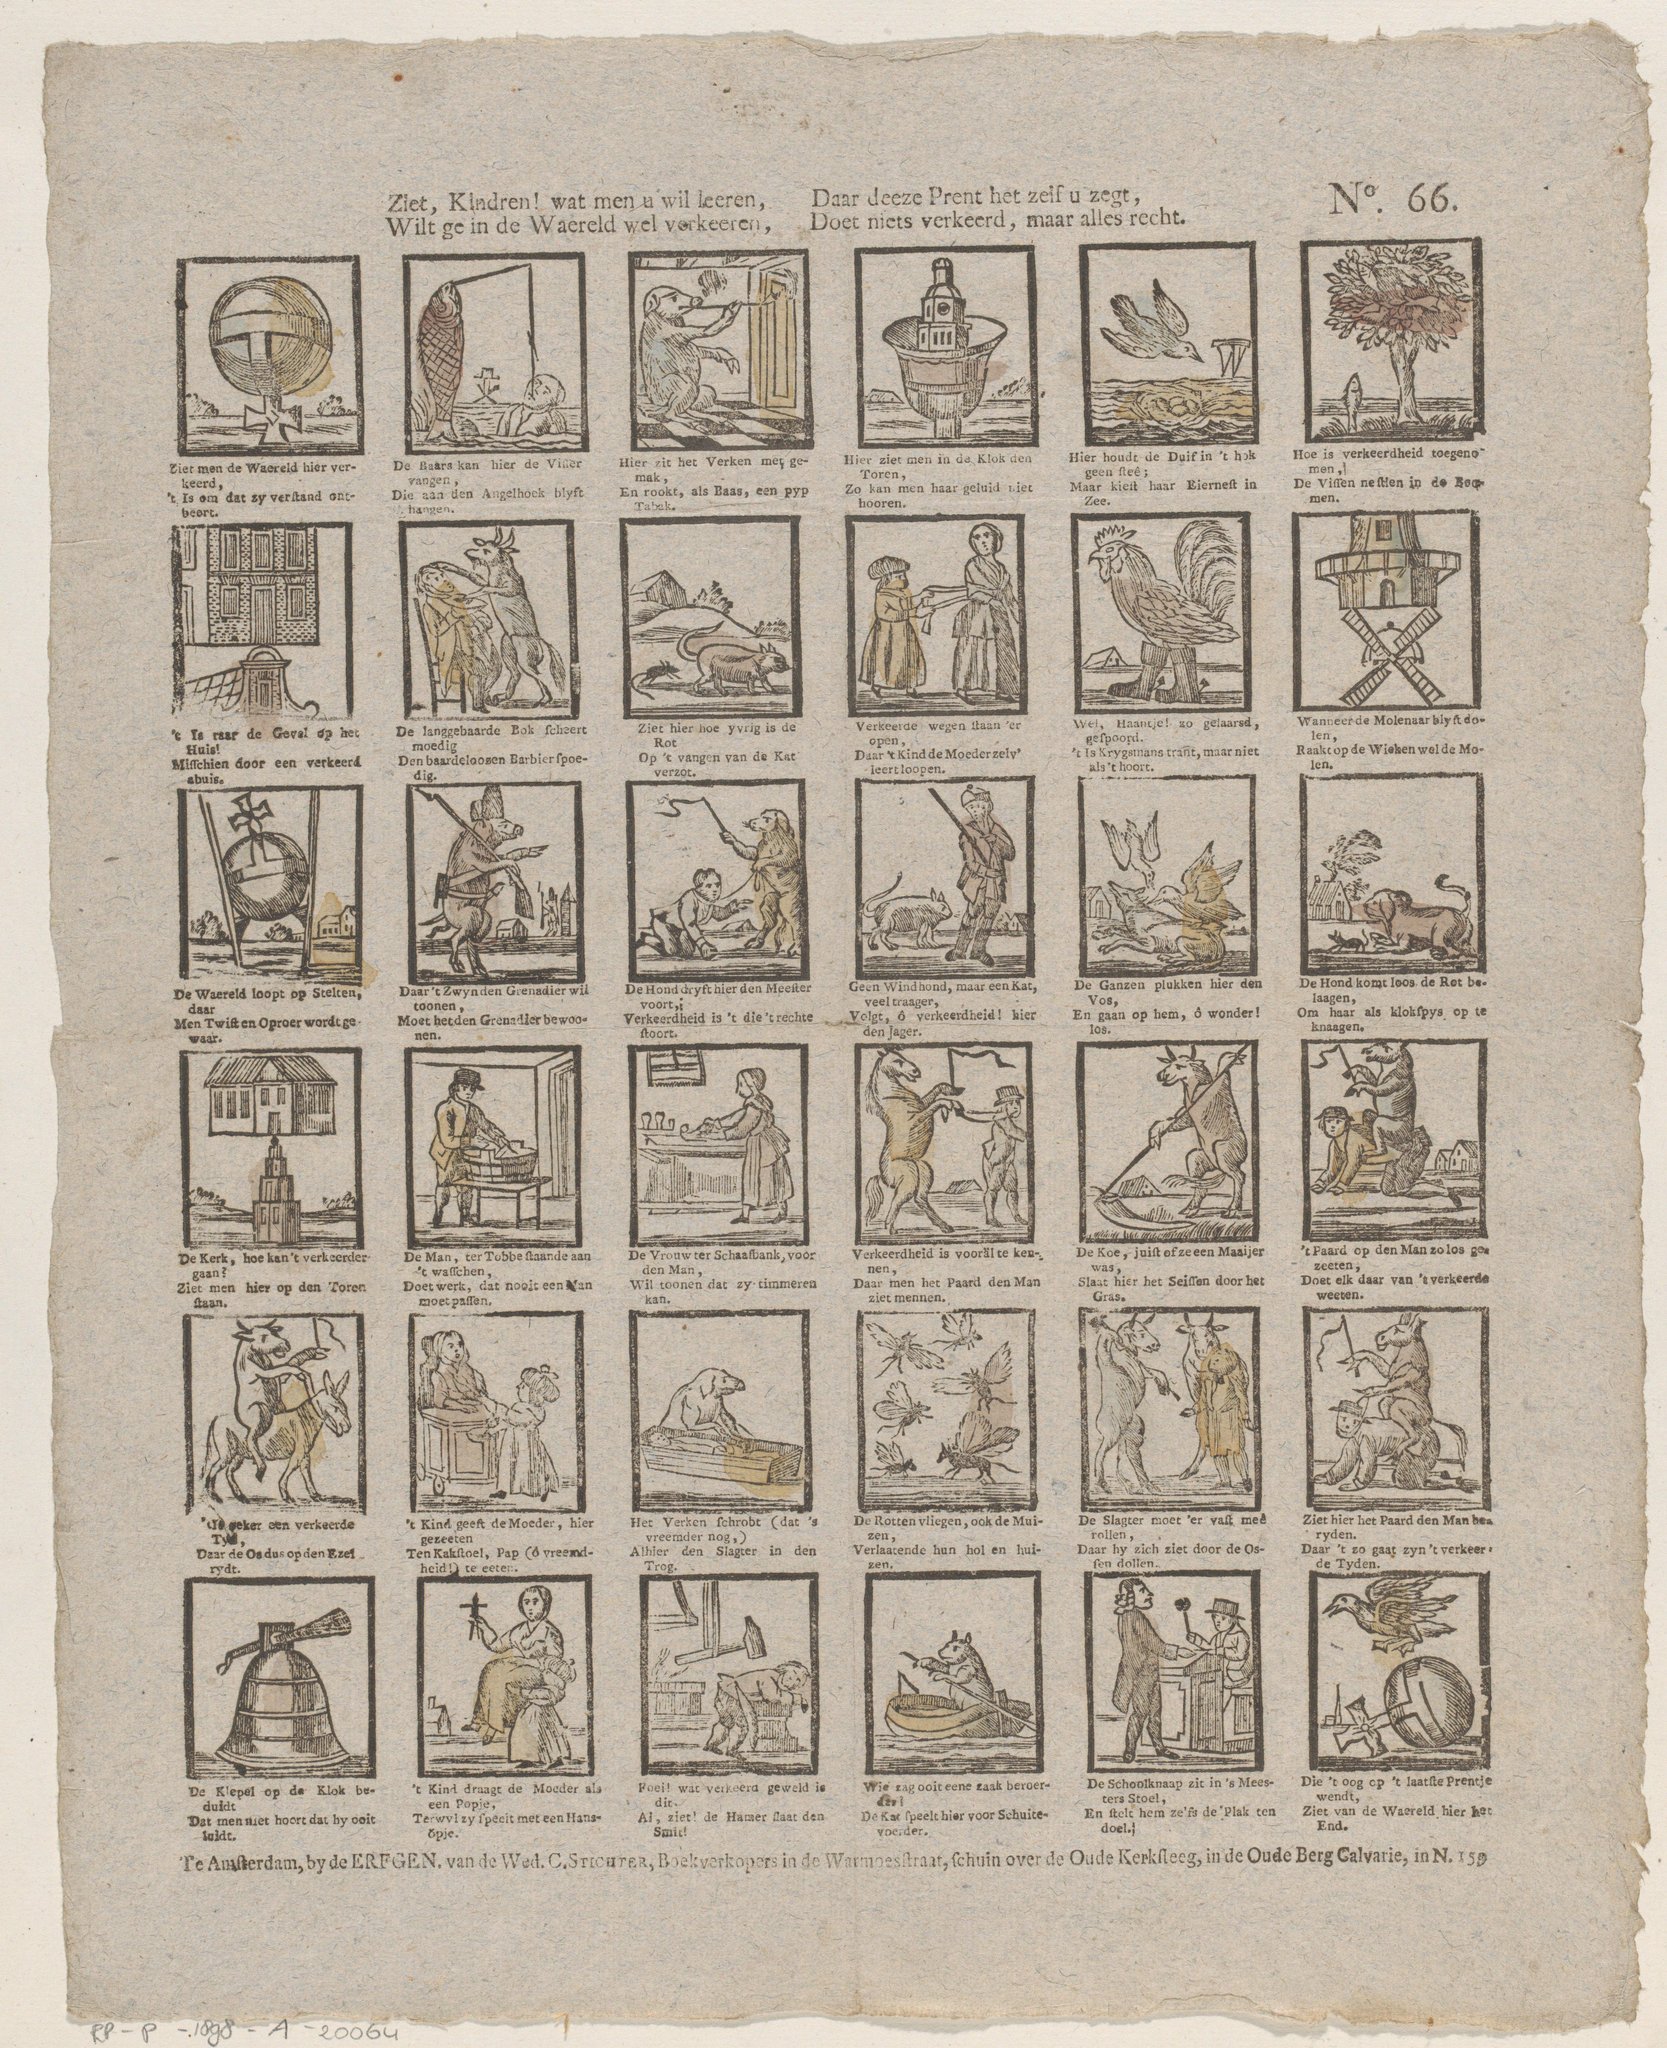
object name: print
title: Ziet, kindren! wat men u wil leeren, / Wilt ge in de waereld wel verkeeren, / Daar deeze prent het zelf u zegt, / Doet niets verkeerd, maar alles recht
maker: Anonymous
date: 1715-1813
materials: paper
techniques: colour, letterpress printing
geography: netherlands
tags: 'mundus inversus', the reversed world, the topsy-turvy world, 'le monde bestourné', animals acting as human beings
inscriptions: collector's mark: Lugt 2228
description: Blad met 36 voorstellingen van de verkeerde wereld, waar onder andere dieren zich als mensen gedragen. Onder elke afbeelding een tweeregelig vers. Genummerd rechtsboven: No. 66.